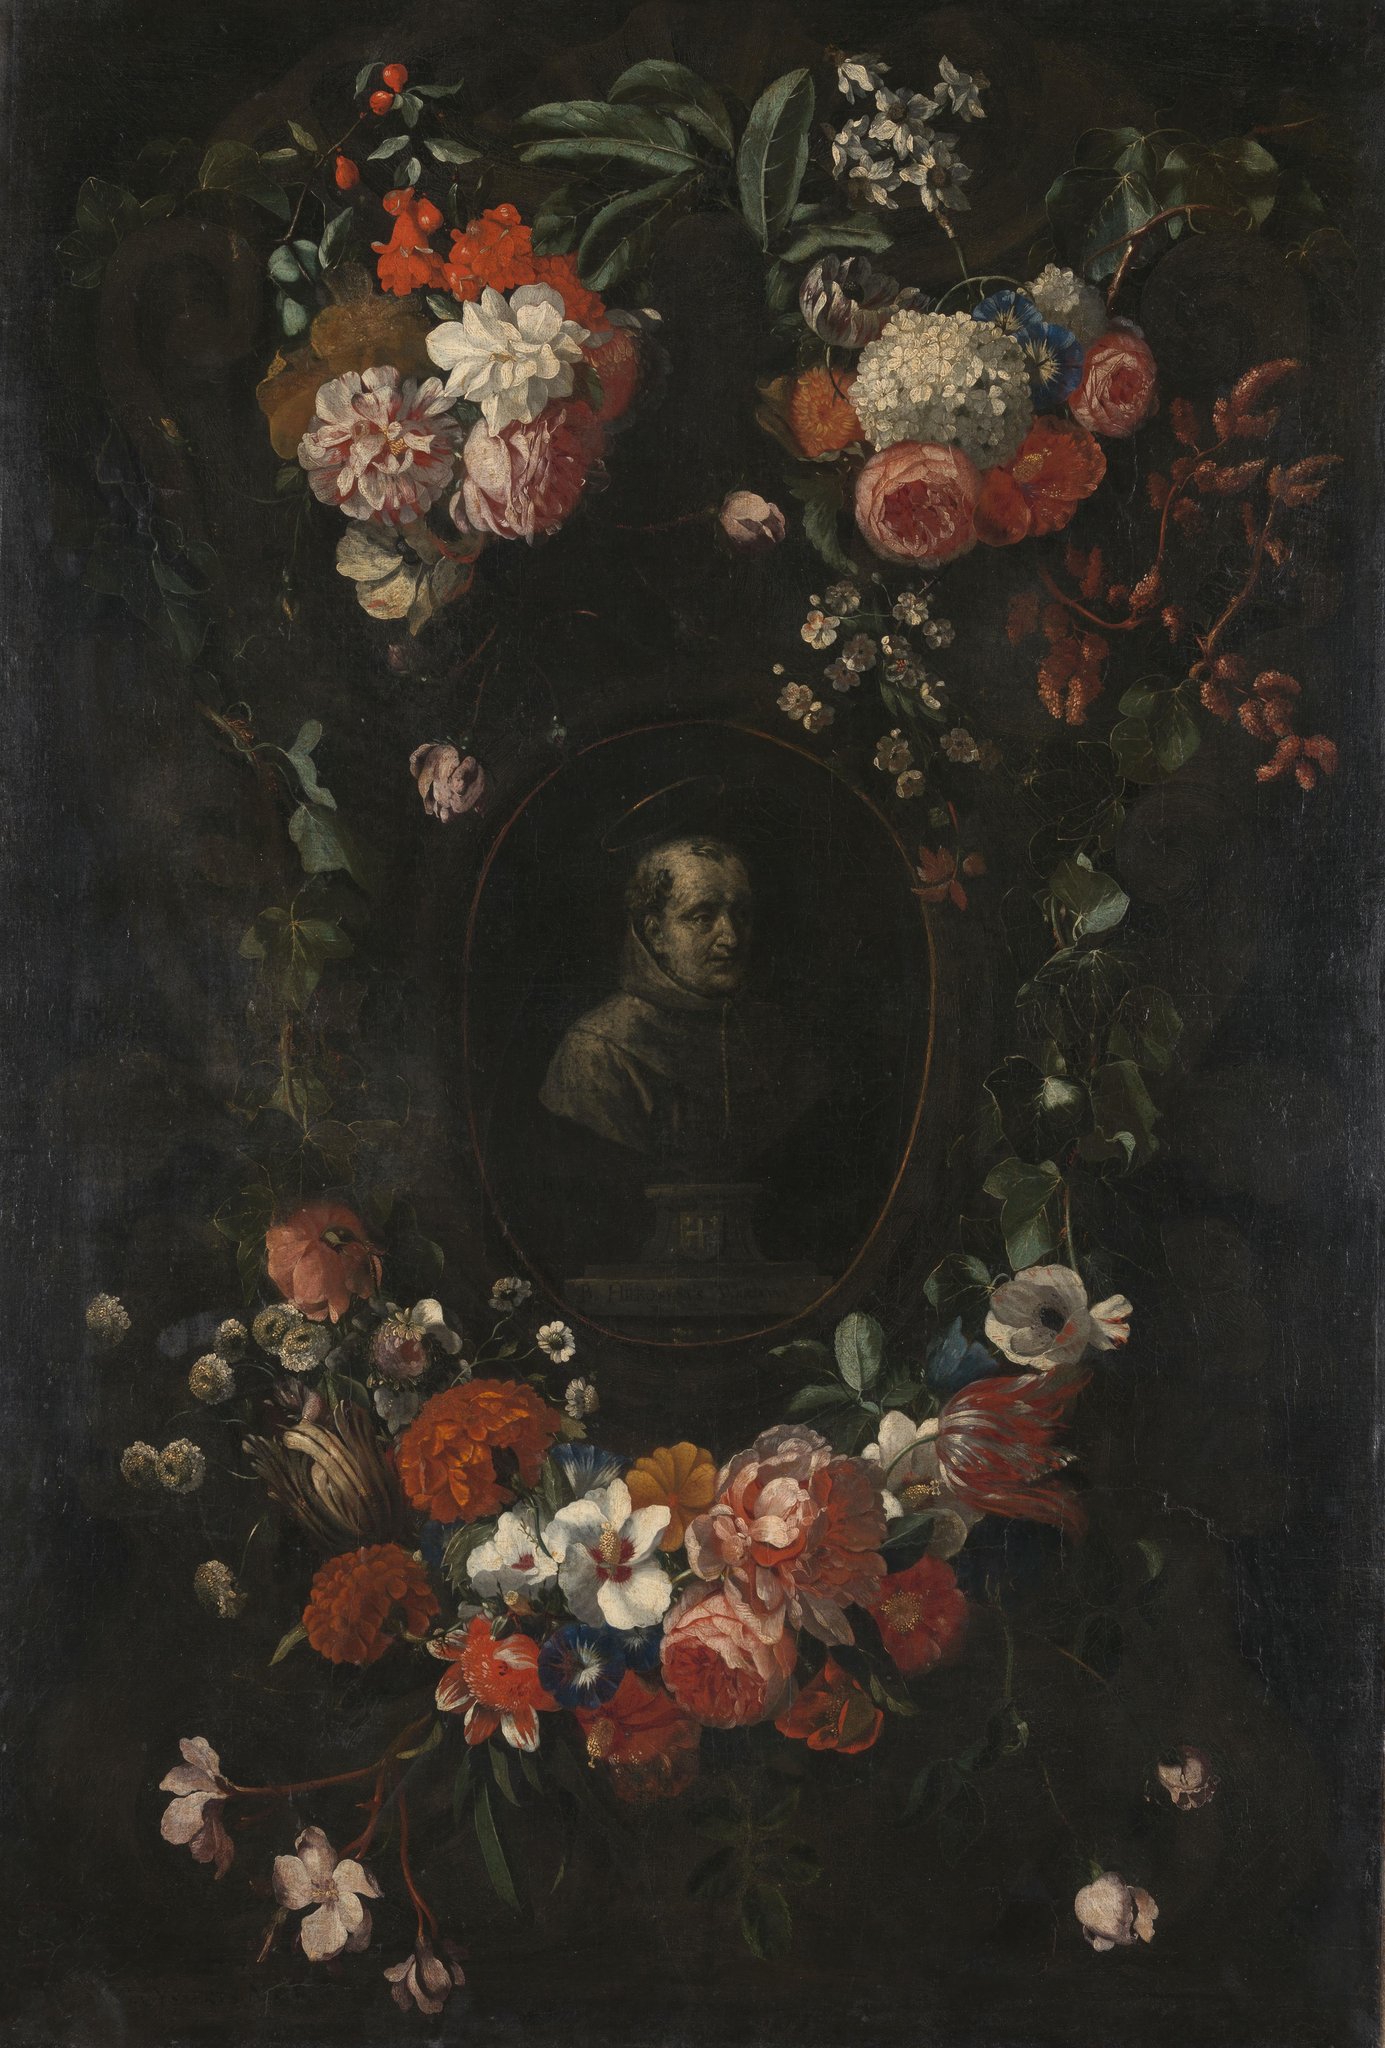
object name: painting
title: Feigned Sculpted Bust of the Blessed Hieronymus Werdanus Set in a Feigned Stone Cartouche, Decorated with a Swag and Two Bunches of Flowers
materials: canvas, oil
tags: brielle, priest, 'trompe l'oeil', garland, wreath, piece of sculpture, reproduction of a piece of sculpture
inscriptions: coat of arms, centre, on the socle: De gueules à la croix d’argent, cantonné de quatre croisettes pattées du même, signature, centre, in the oval to the left of the bust: ‘DT·F.’ D and T in monogram, signature, bottom left: ‘F[RATER]·G[UALTERUS]·GYSAERTS·MIN[OR]·F[ECIT]’, inscription, centre, beneath the socle on the ledge: ‘B[EATUS]·Hieronymus WERDANUS’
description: Bloemenkrans om een portretbuste van Hieronymus van Weert (Werdanus), martelaar van Gorkum. Maakt deel uit van een serie van 19 schilderijen met portretten van de martelaren van Gorkum, vervaardigd voor de voormalige Minderbroederskerk te Mechelen. Ontstaan vóór de zaligverklaring op 9 juli 1676.